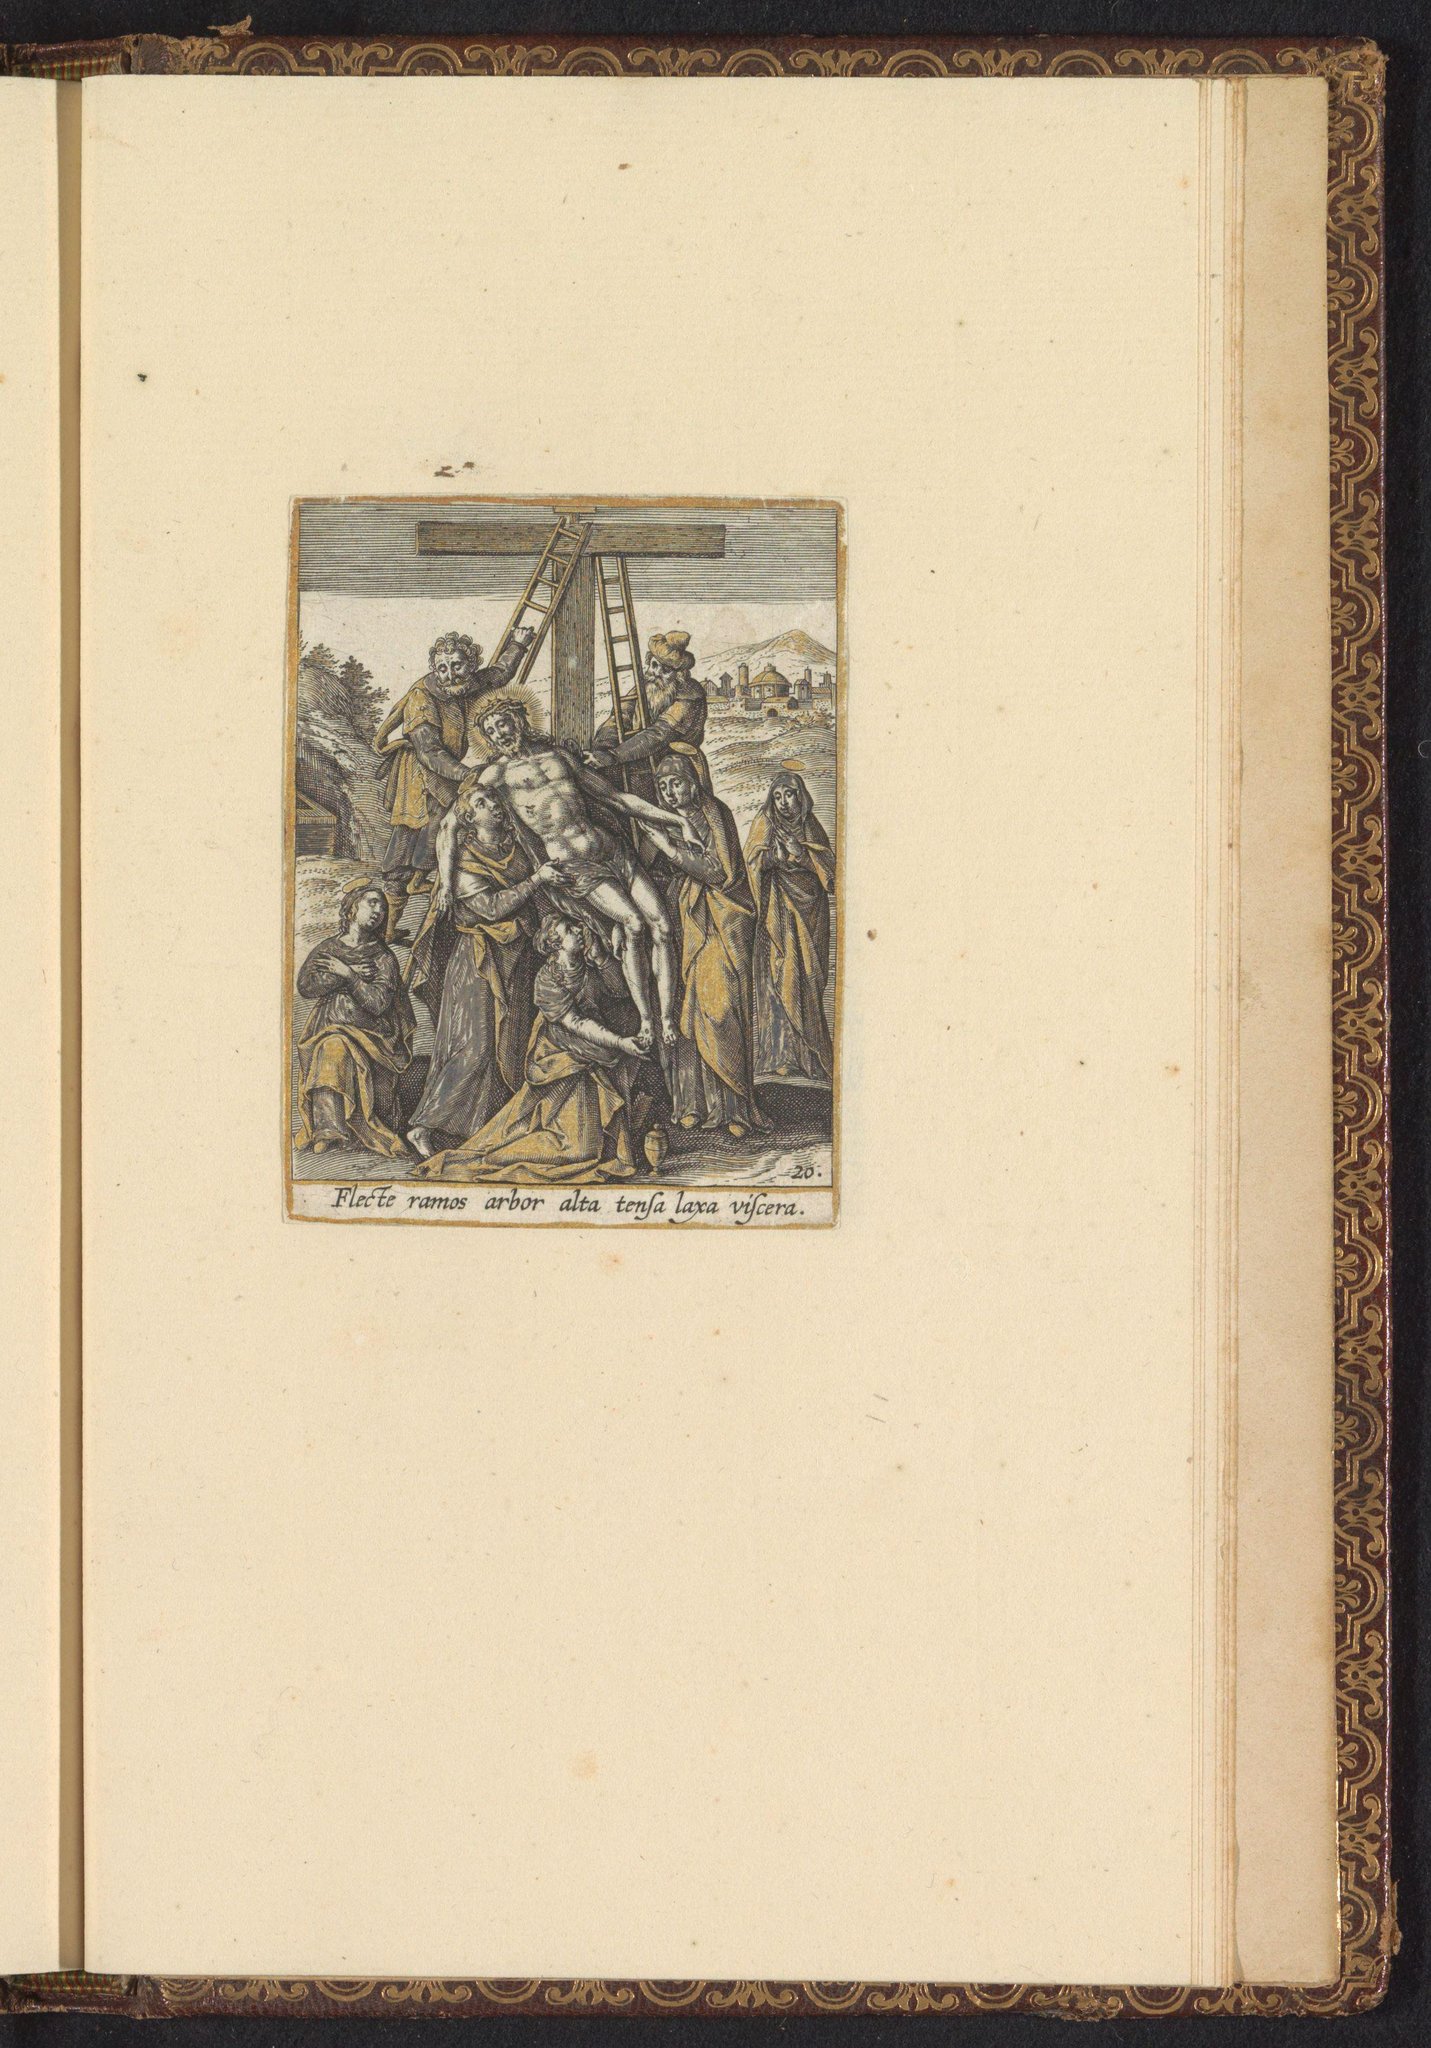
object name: print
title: Kruisafneming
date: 1580-1590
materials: gold, paper, silver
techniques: engraving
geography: antwerp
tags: descent from the cross: christ is taken down from the cross, usually by nicodemus and joseph of arimathaea who are standing on the ladders (both arms of christ detached)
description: Kruisafneming. Onderdeel van de prentserie over de passie van Christus: Passio et resurrectio D.N. Iesu Christi. Edita et excusa ab Ad. Collaert. In prentalbum met twee reeksen van respectievelijk 34 en 24 gravures met scènes uit het leven en het lijdensverhaal van Christus.